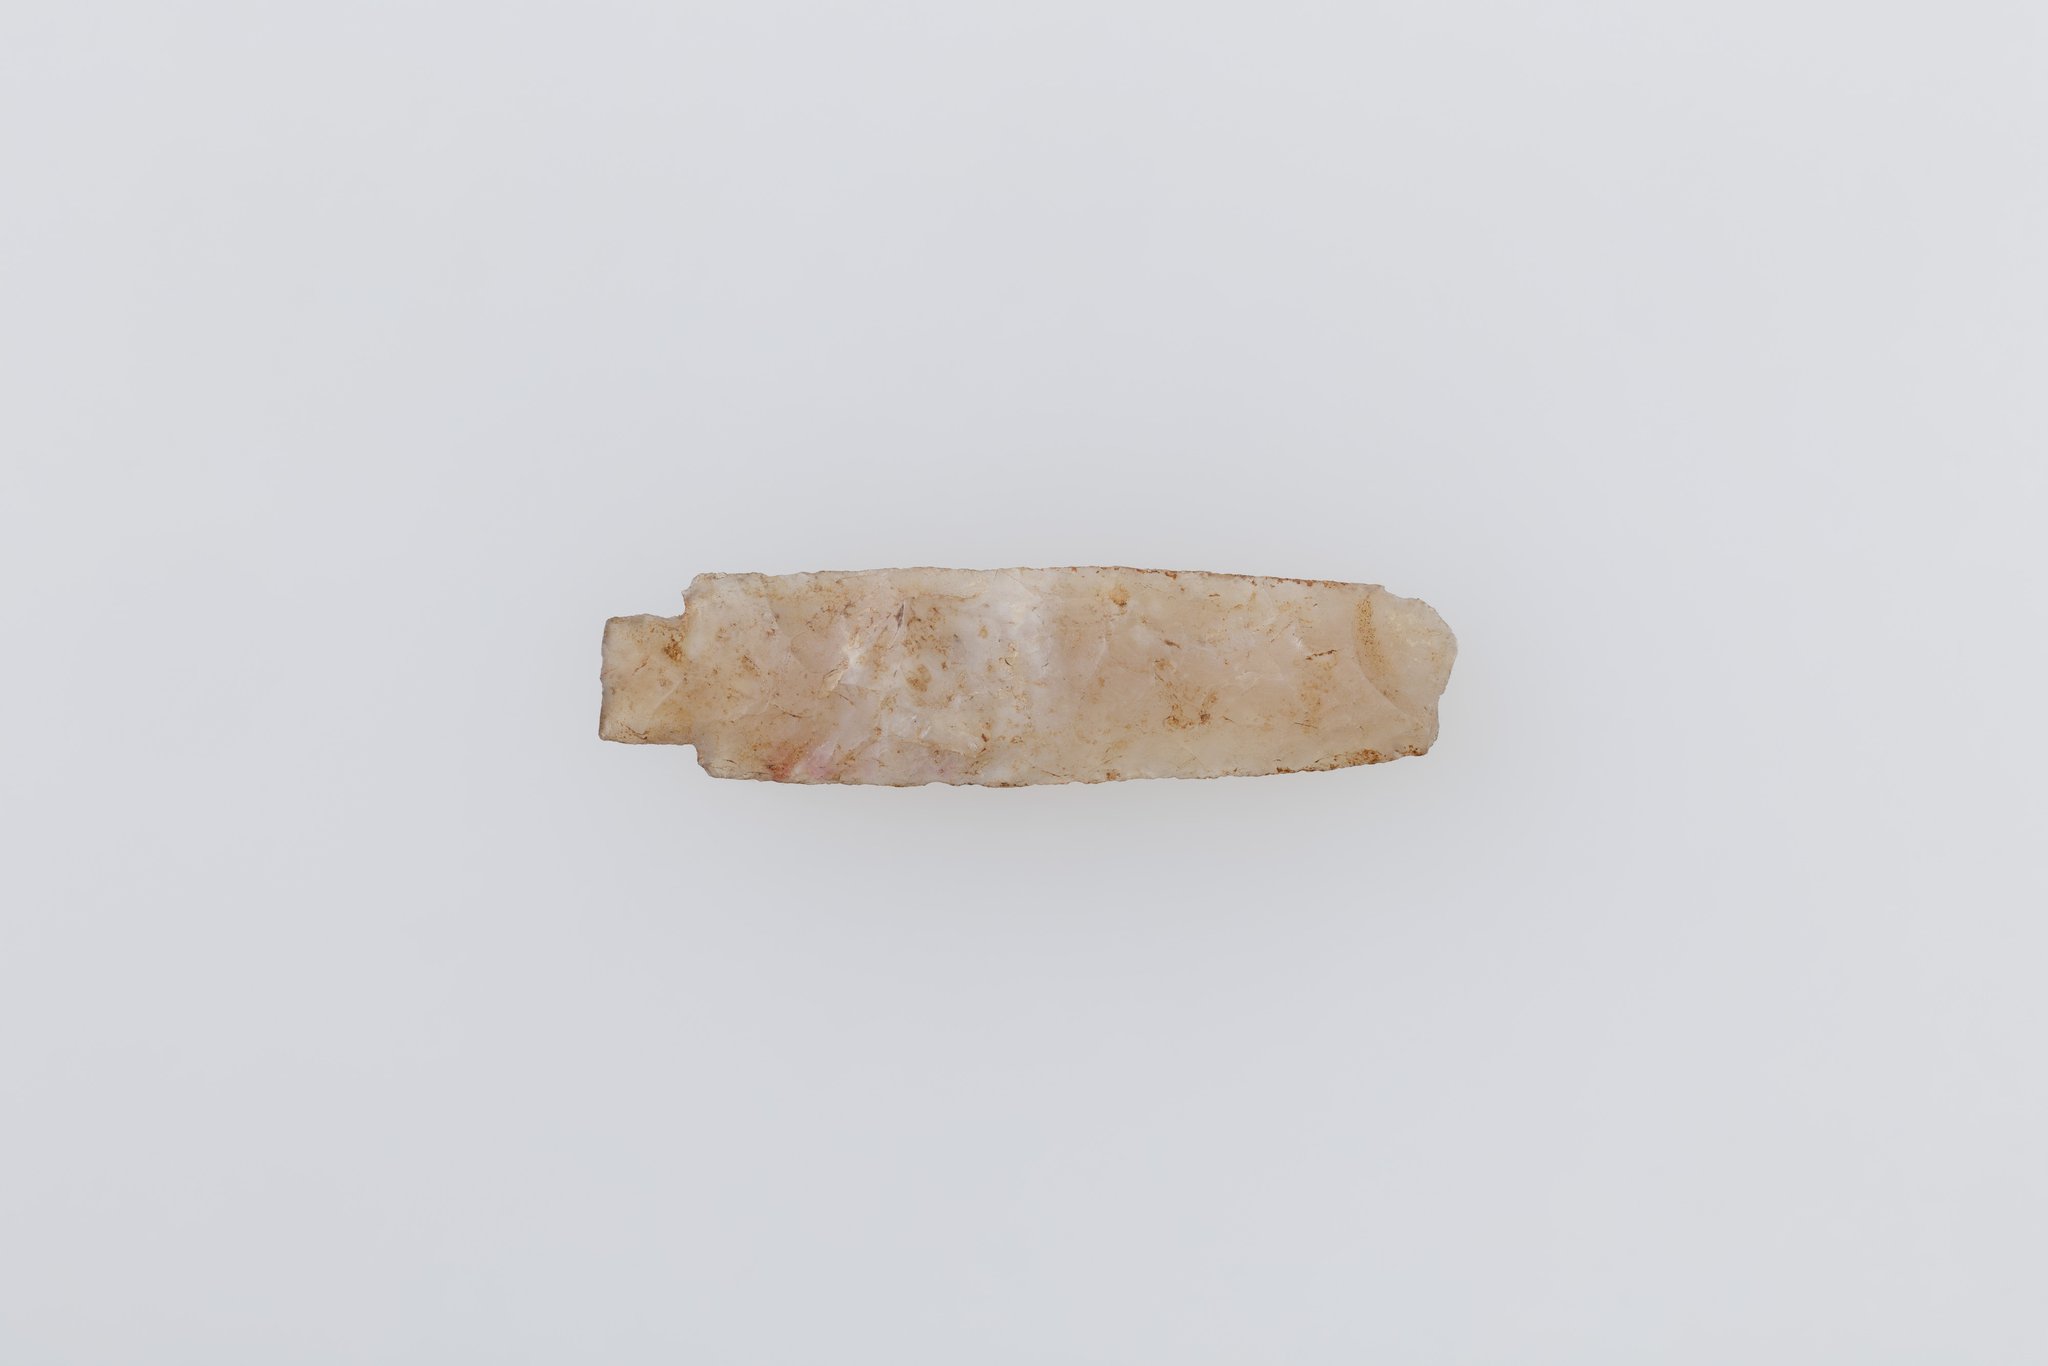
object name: arrowhead, projectile point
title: Projectile Point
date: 3100-2649 BCE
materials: stone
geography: egypt